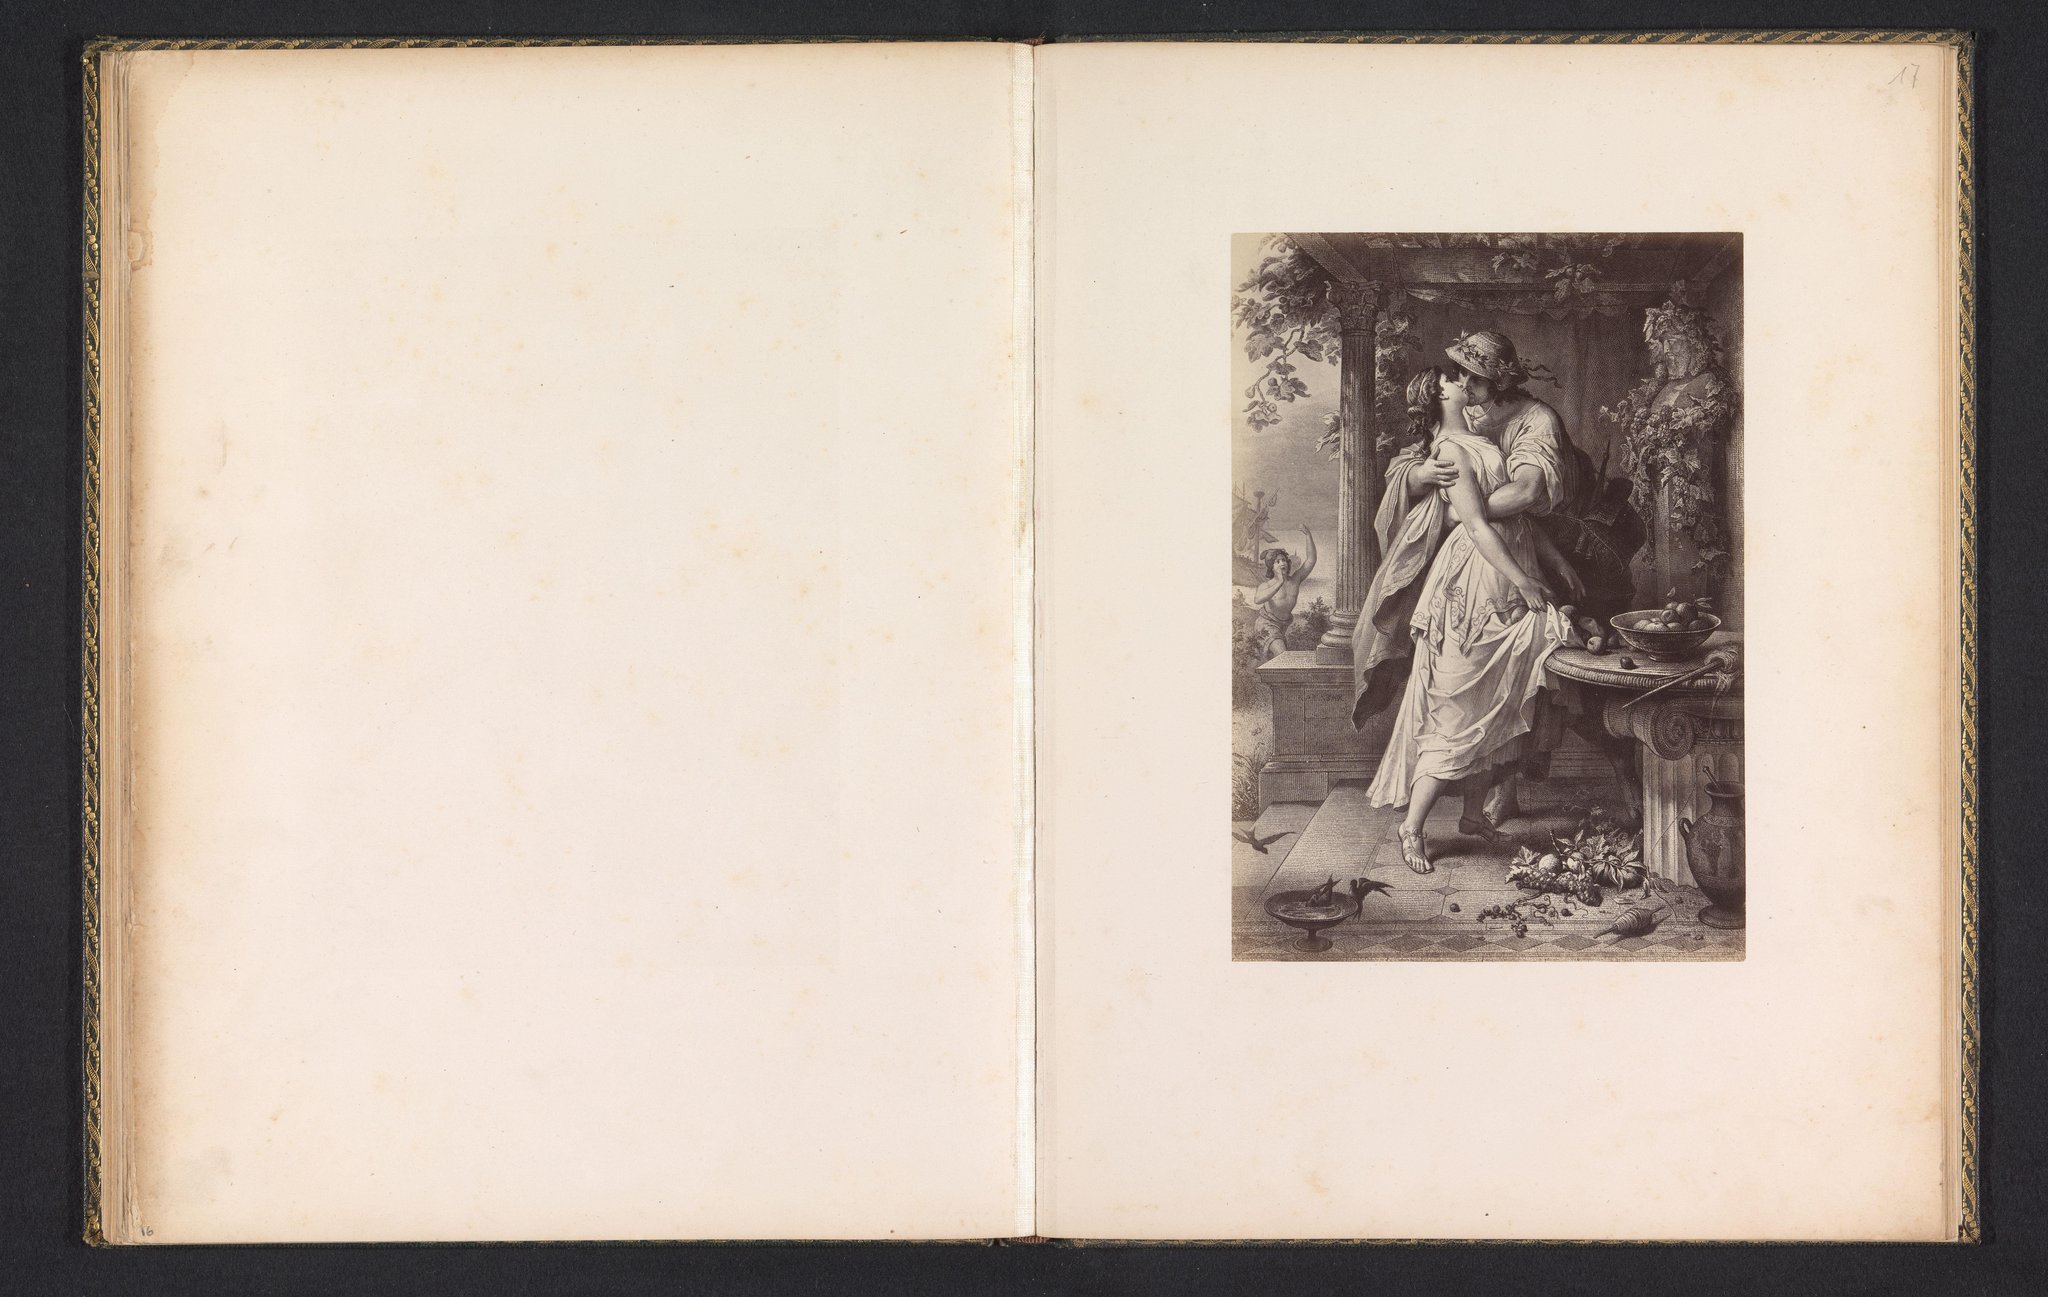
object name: photograph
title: Fotoreproductie van een prent, voorstellende Alexis kust Dora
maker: Anonymous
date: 1875-1885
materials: photographic support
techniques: albumen print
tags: (lovers) kissing each other